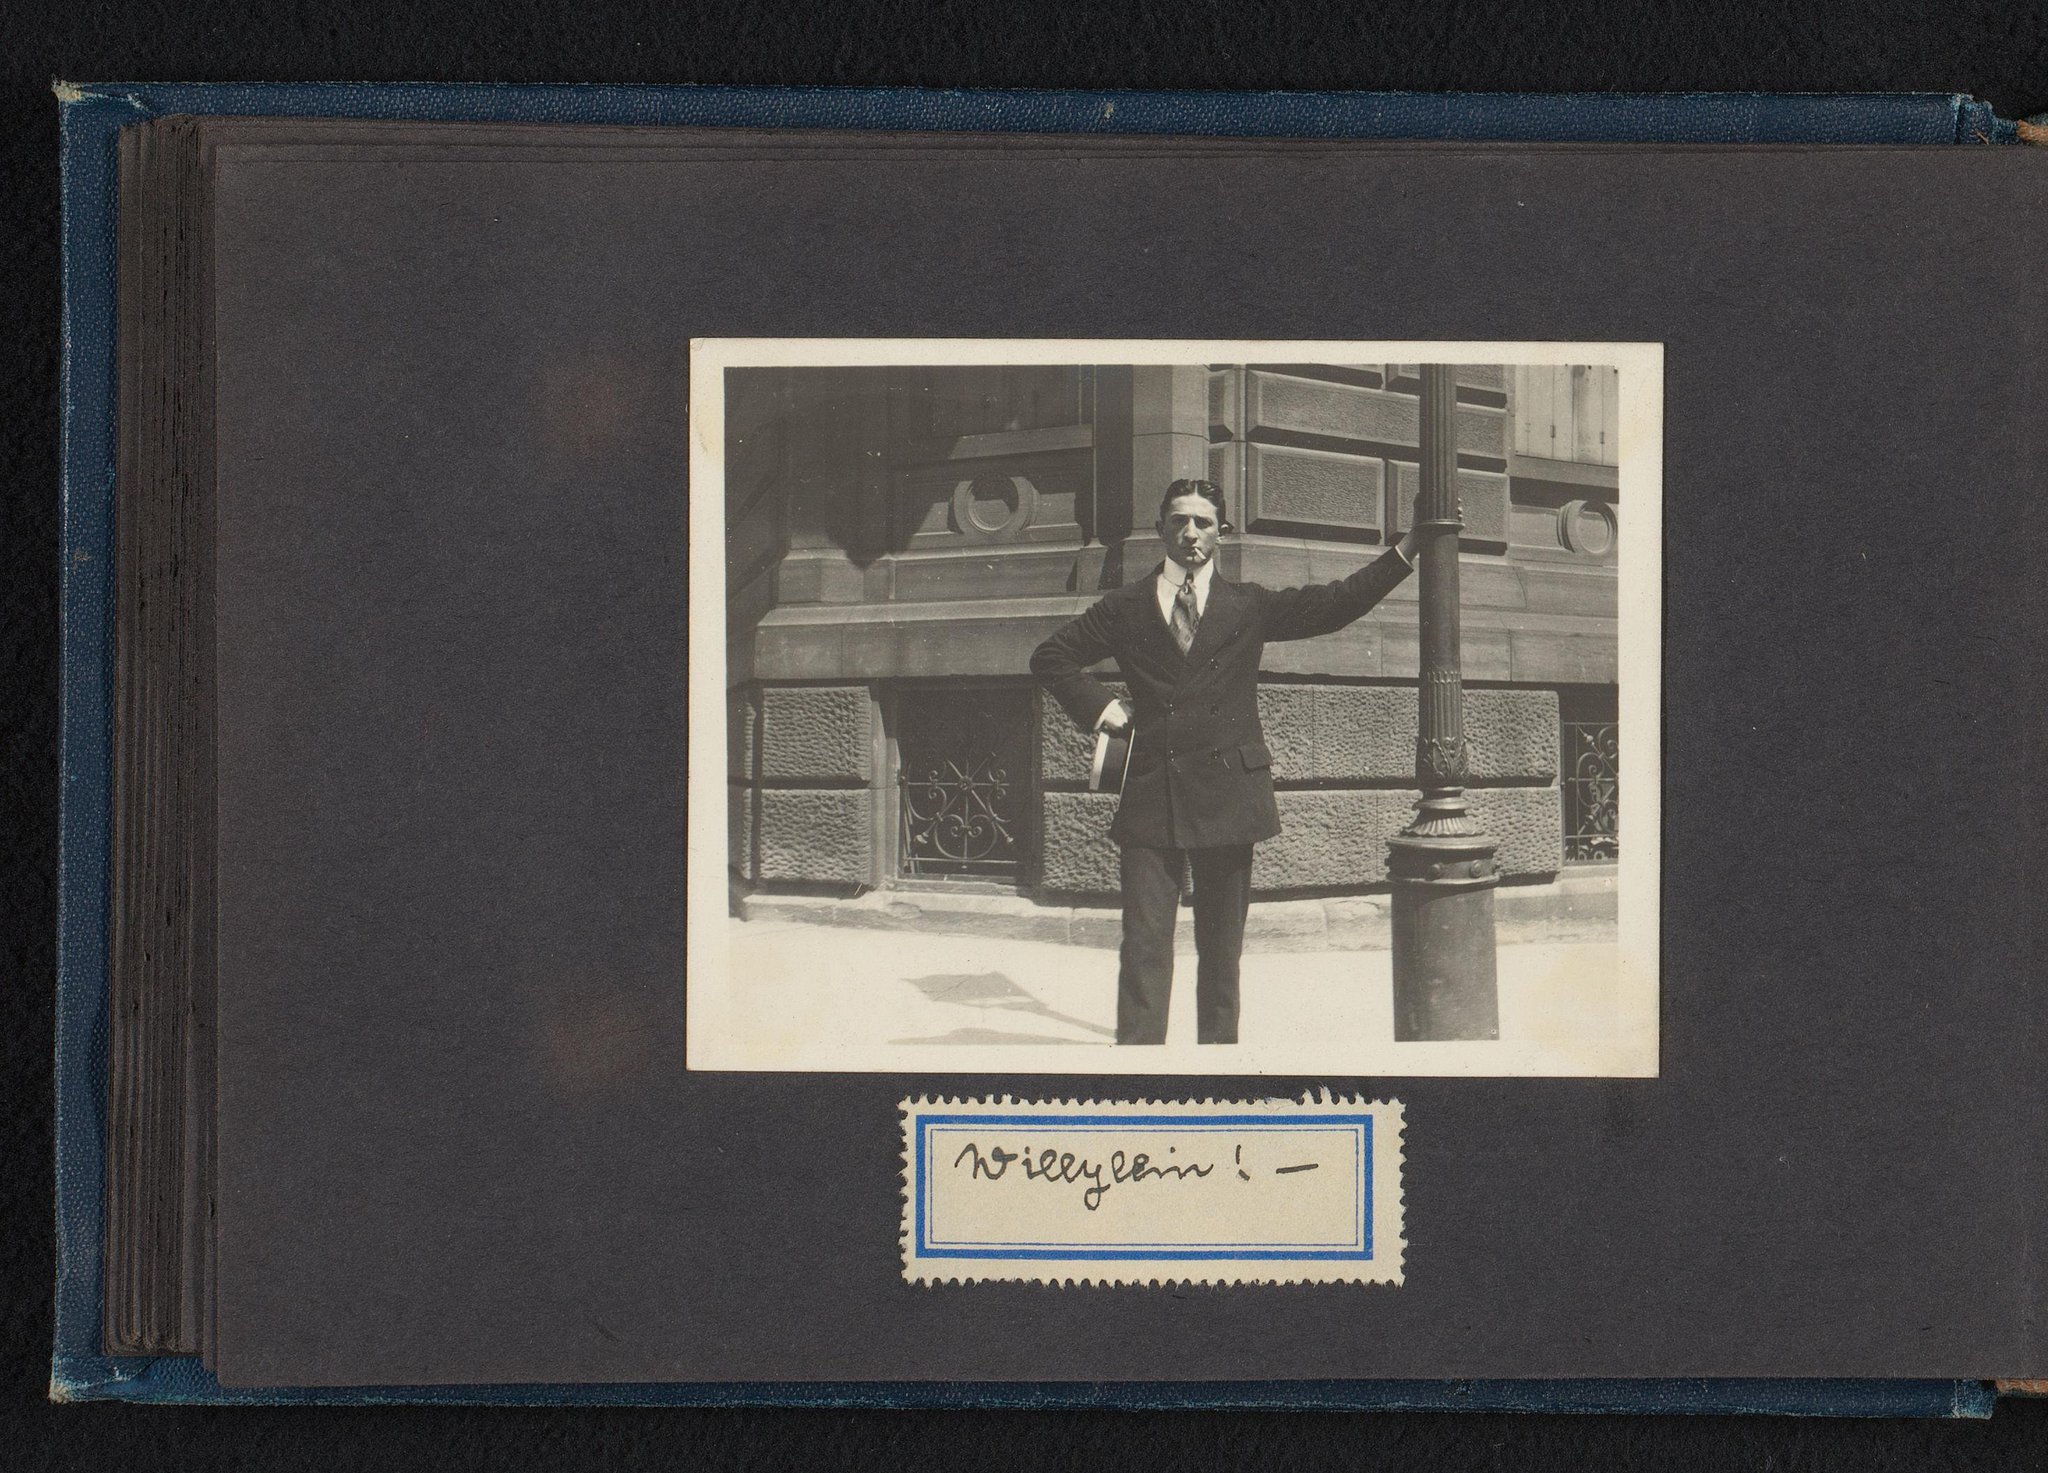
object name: photograph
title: Willy Moos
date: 1913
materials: paper, photographic support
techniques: gelatin silver print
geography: germany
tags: else wachenheimer-moos, willy moos, historical persons, germany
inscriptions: inscription: ‘Willylein!’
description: Albumblad met een foto van Willy Moos, voor zijn vertrekt naar China. Onderdeel van het fotoalbum van Else Wachenheimer-Moos en haar broers Arthur en Willy Moos en anderen in de periode 1913-1918.